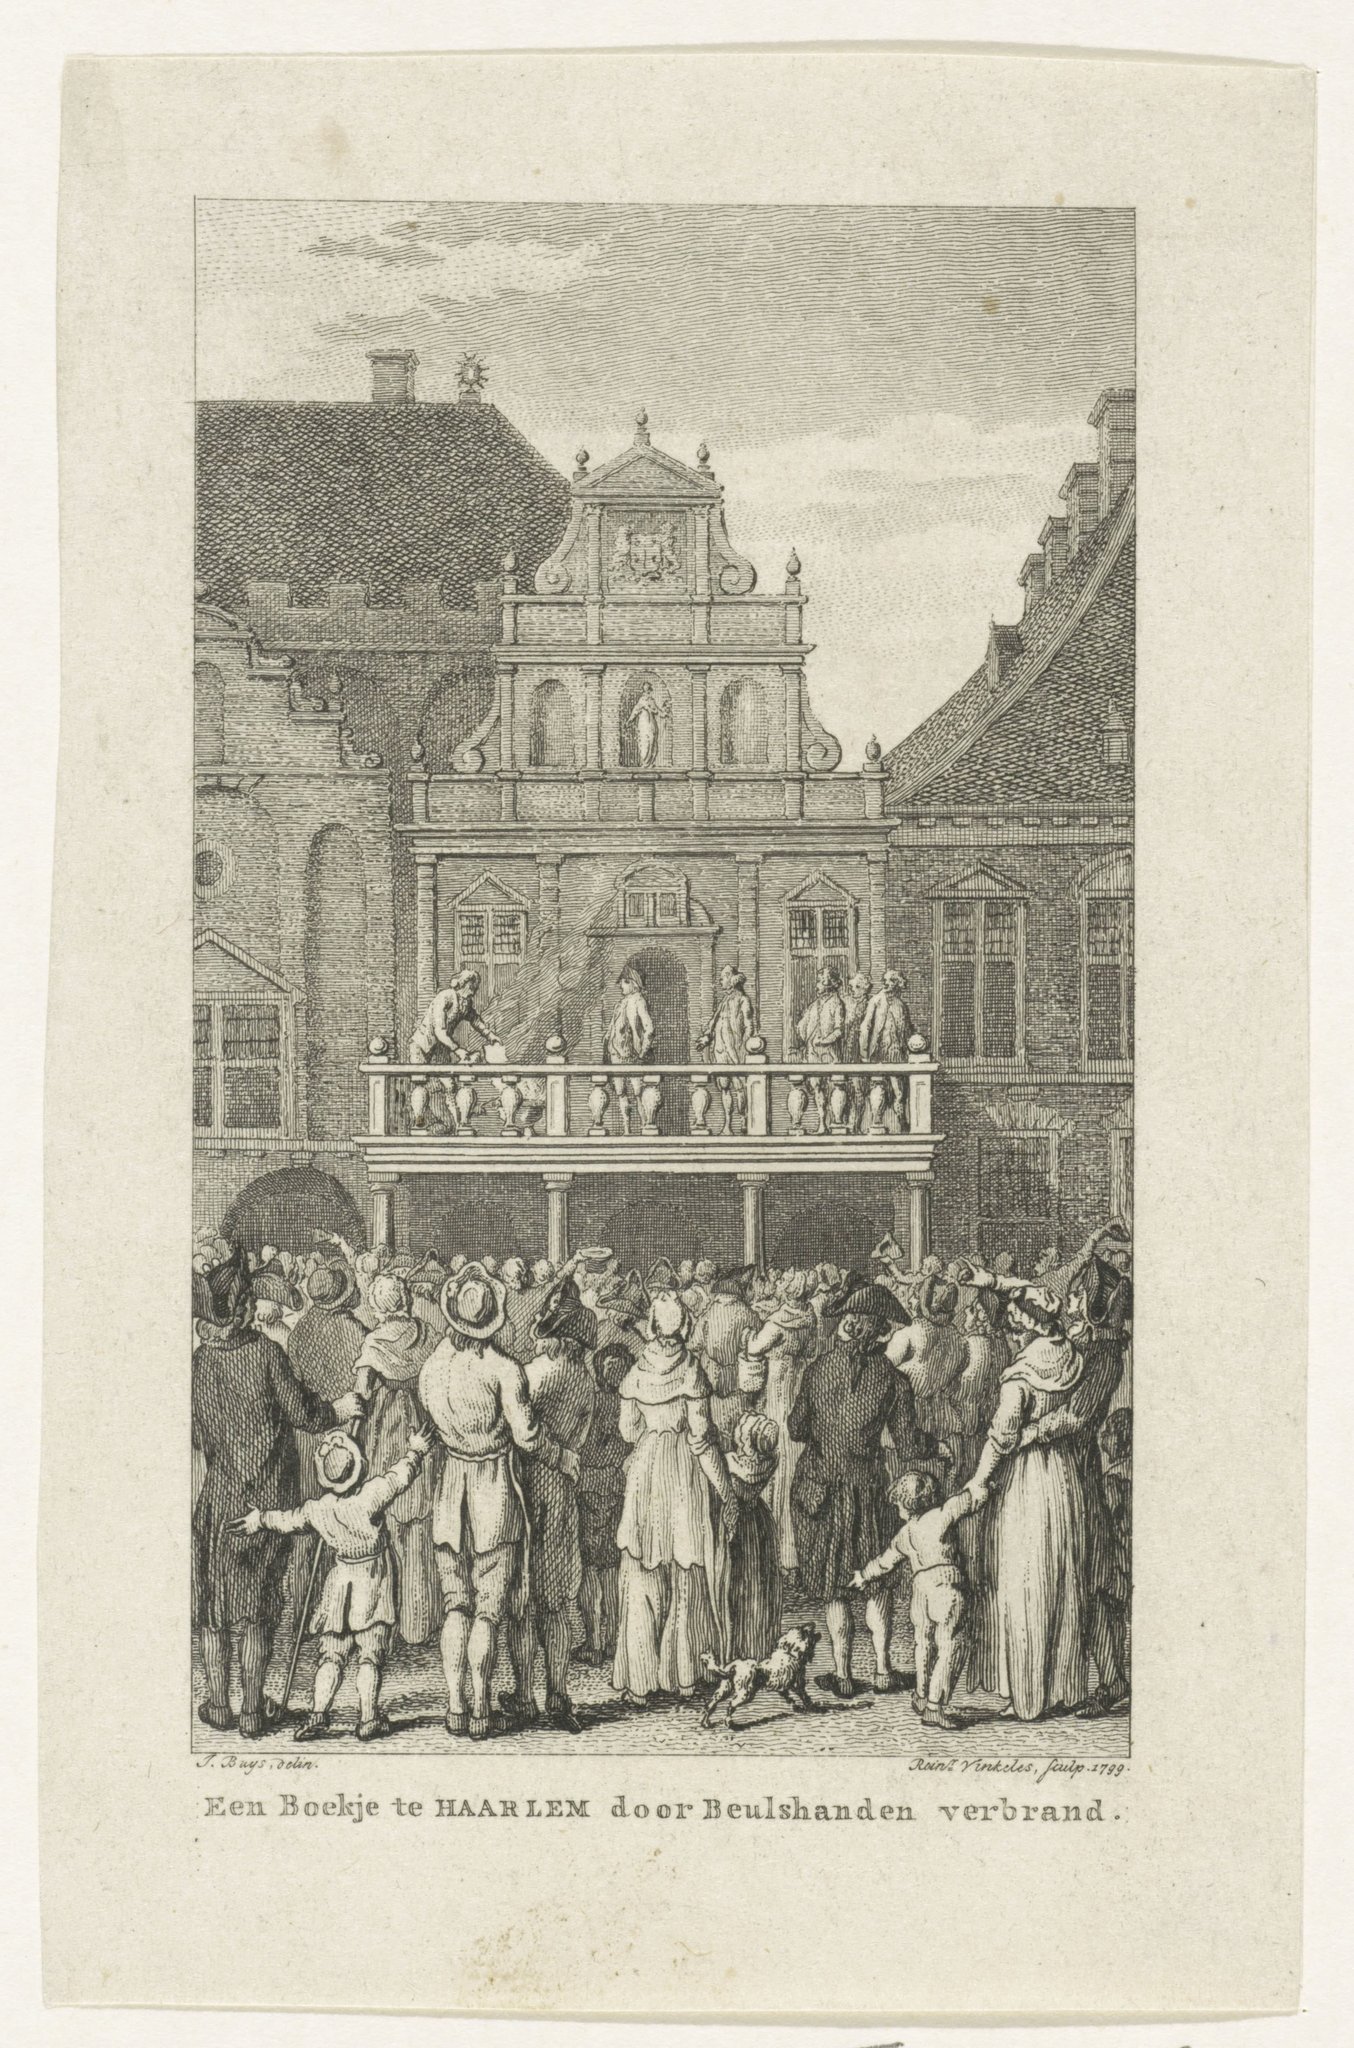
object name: history print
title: Een boekje te Haarlem door beulshanden verbrand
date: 1799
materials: paper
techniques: engraving, etching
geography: amsterdam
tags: (revolutionary action with the help of) libels, broadsides, cartoons, etc., execution in effigy, townhall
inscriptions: collector's mark: Lugt 2228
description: Gebruikt als illustratie in: Loosjes, P.A. Vaderlandsche historie, vervattende de geschiedenissen der Vereenigde Nederlanden […] Ten vervolge van Wagenaars Vaderlandsche historie. 48 delen. Amsterdam: Johannes Allart, 1786-1811, dl. 23 (1799), tussen p. 284 en 285. Het veroordeelde pamflet is: Pro en contra, of De vrĳmoedige raad, aan de inwooners van Nederland, in't algemeen, en aan de burgery van Haarlem in't byzonder, benevens derzelver antwoord. Naarden: C. van Tricht Jacobsz, 1790.